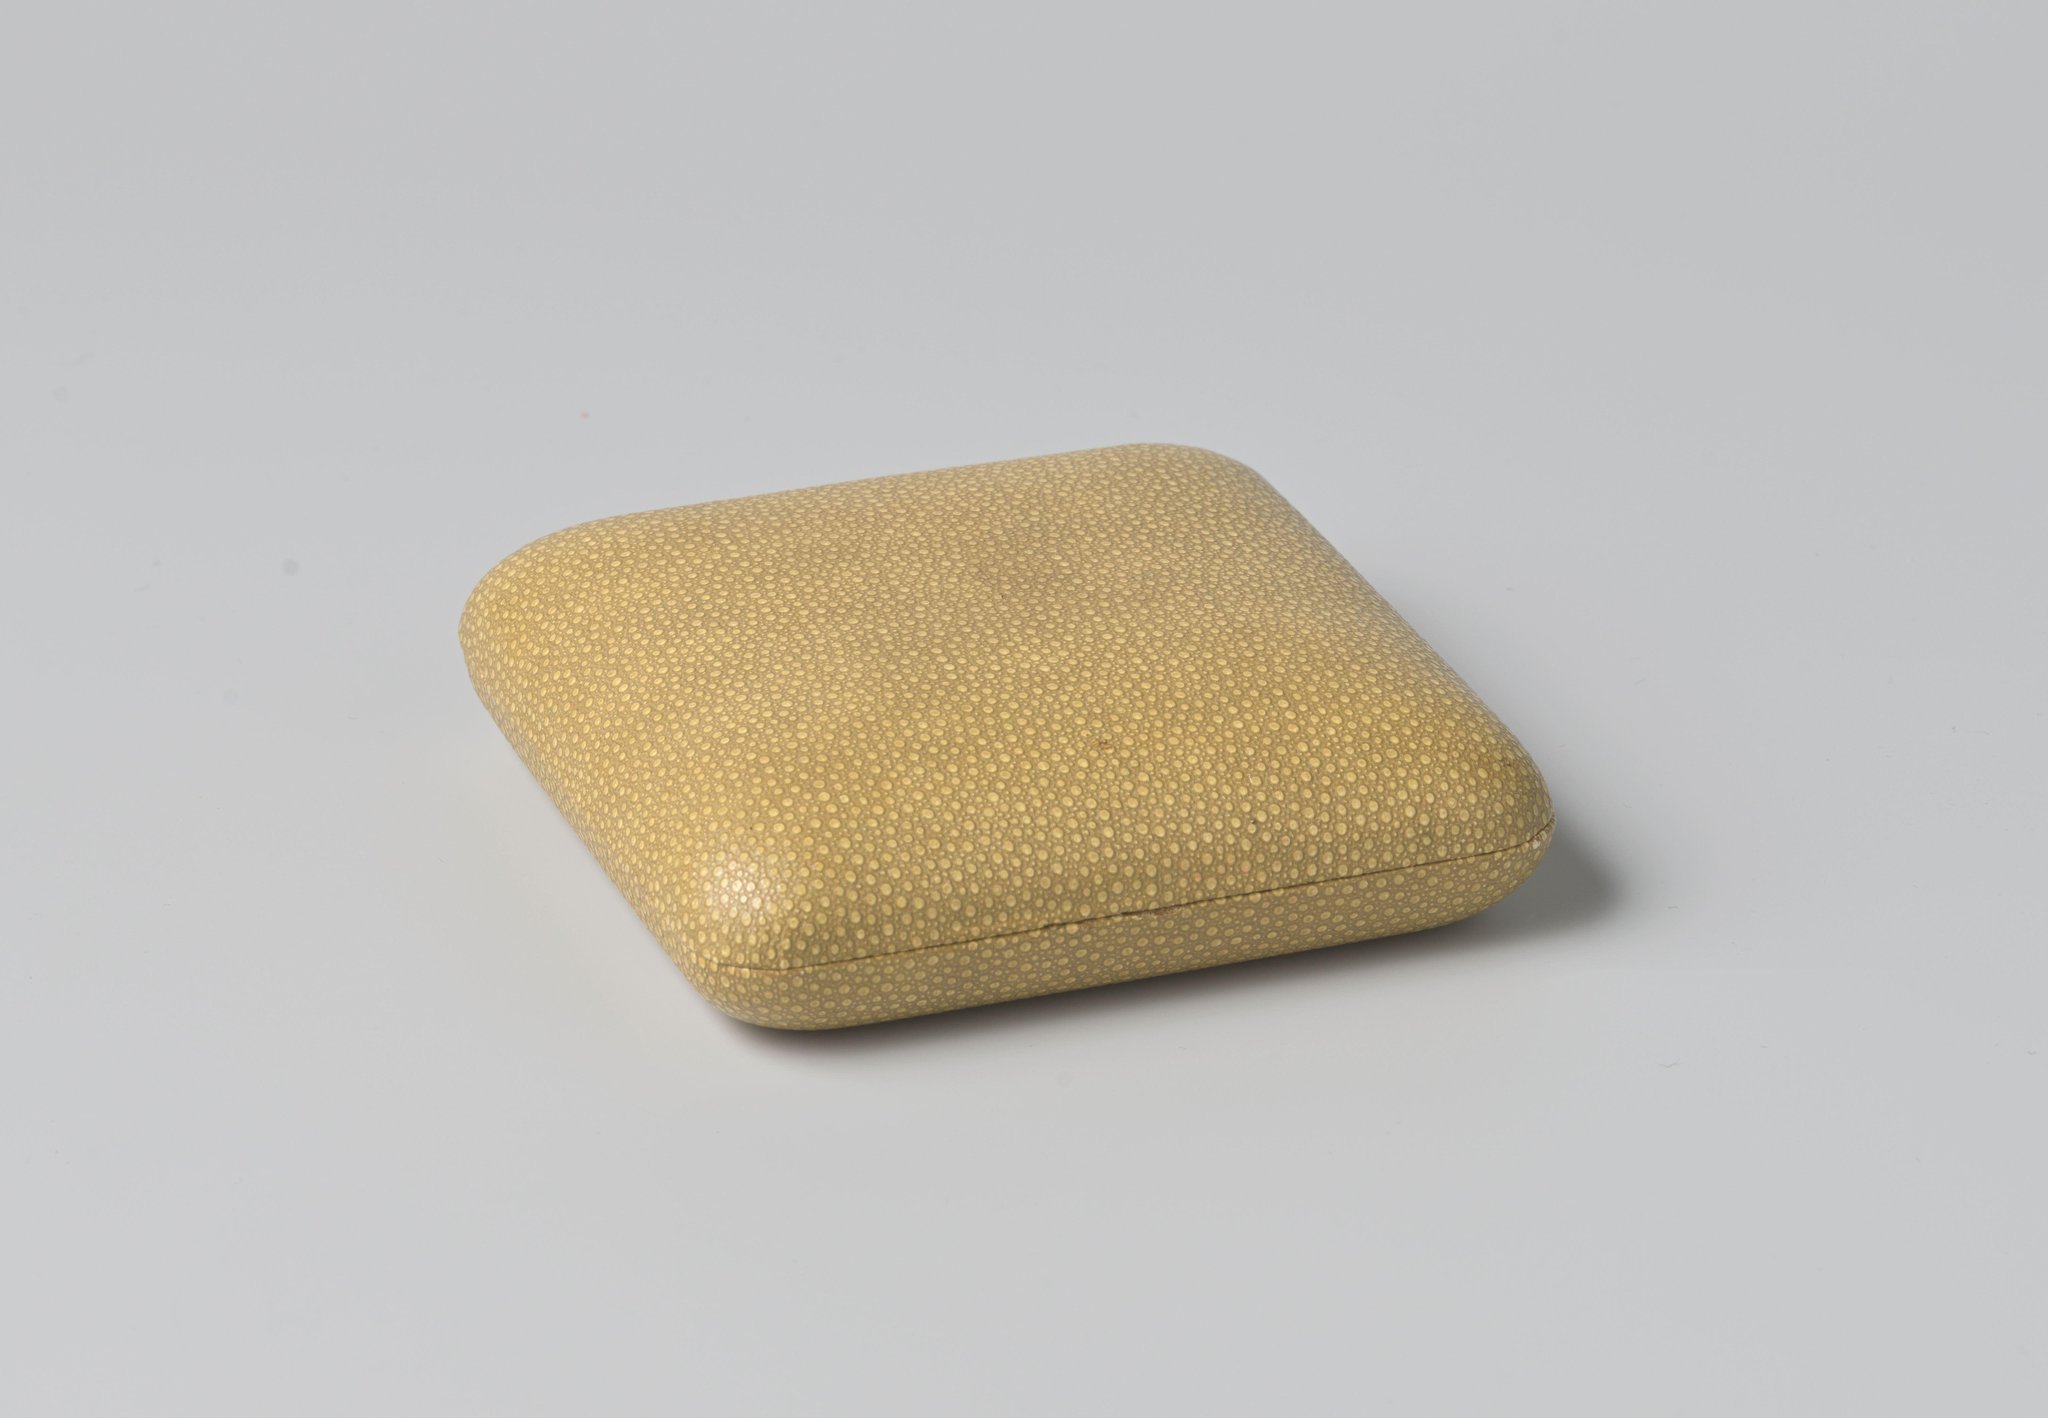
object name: juwelendoos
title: Vierkante juwelendoos met bollend deksel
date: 1400-1950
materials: leather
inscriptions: maker's mark: ‘V.R.’, alloy mark: ‘585 in ovaal (vanaf 1955)’, alloy mark: ‘adelaarskop naar rechts (vanaf 1847)’, maker's mark: ‘W 2 G in achthoek’, mark: ‘M.D.’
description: Vierkante juwelendoos. Op de binnenkant van bollend deksel opdruk van Delplace Bruxelles..